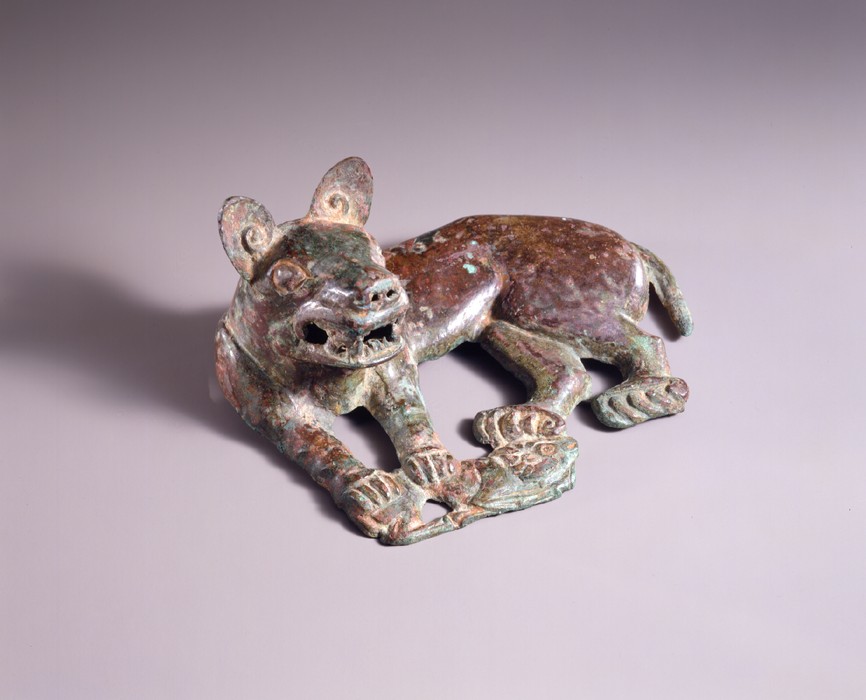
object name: harness ornament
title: Harness Ornament in the Shape of a Carnivore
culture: chinese or mongolian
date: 600-301 BCE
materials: bronze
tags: animals